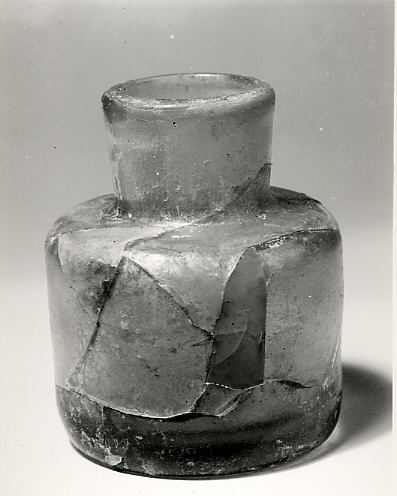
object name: bottle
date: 767-900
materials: glass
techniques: glassblowing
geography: iran